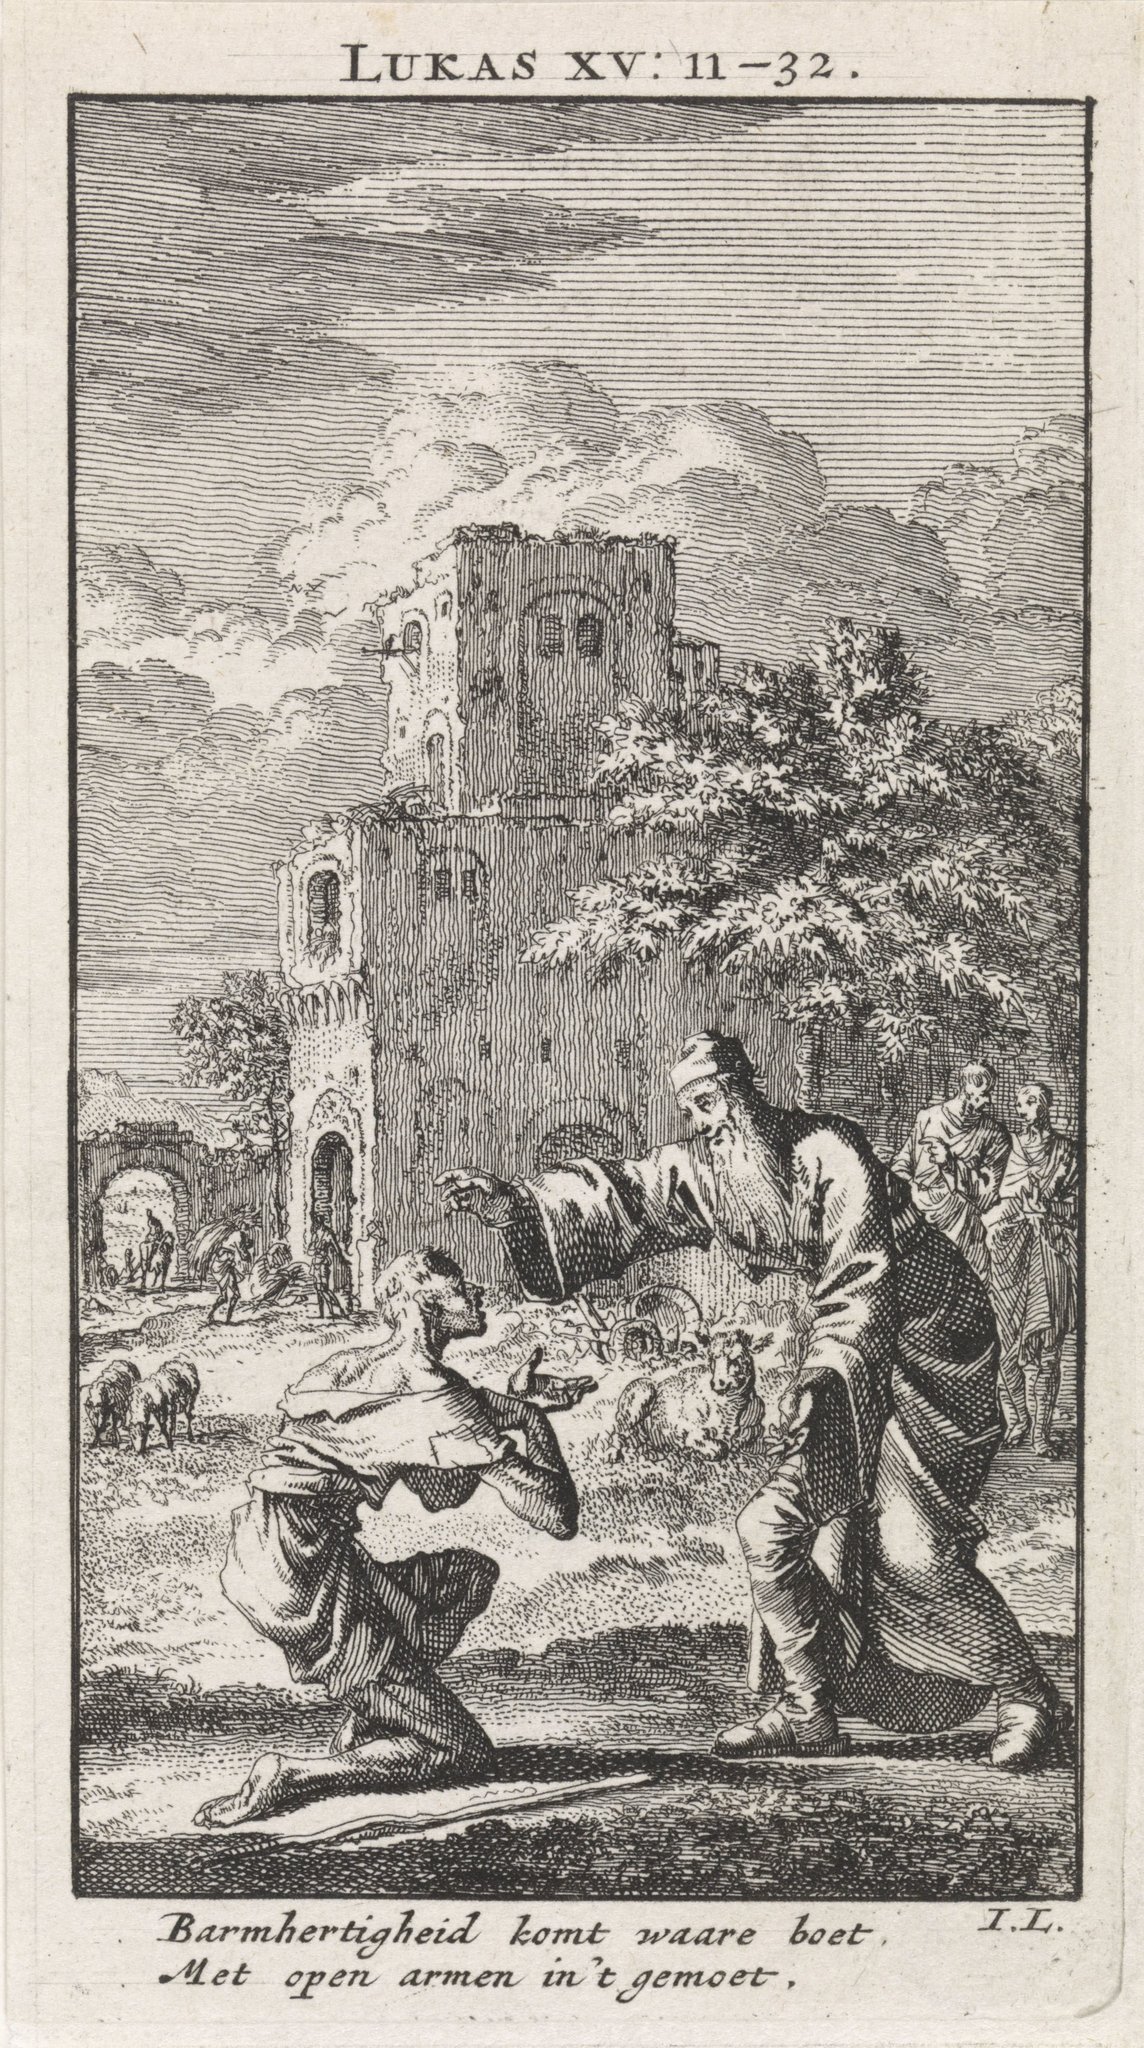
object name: print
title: Terugkeer van de verloren zoon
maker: jan luyken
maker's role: draughtsman, print maker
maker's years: 1649-1712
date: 1712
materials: paper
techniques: etching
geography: amsterdam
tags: the parable of the prodigal son (luke 15:11-32)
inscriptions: collector's mark: Lugt 2228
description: Illustratie voor: Luyken, Jan. Bybel printen. Amsterdam: Pieter Arentsz. II (wed.) en Cornelis van der Sys, 1712, p. 28.